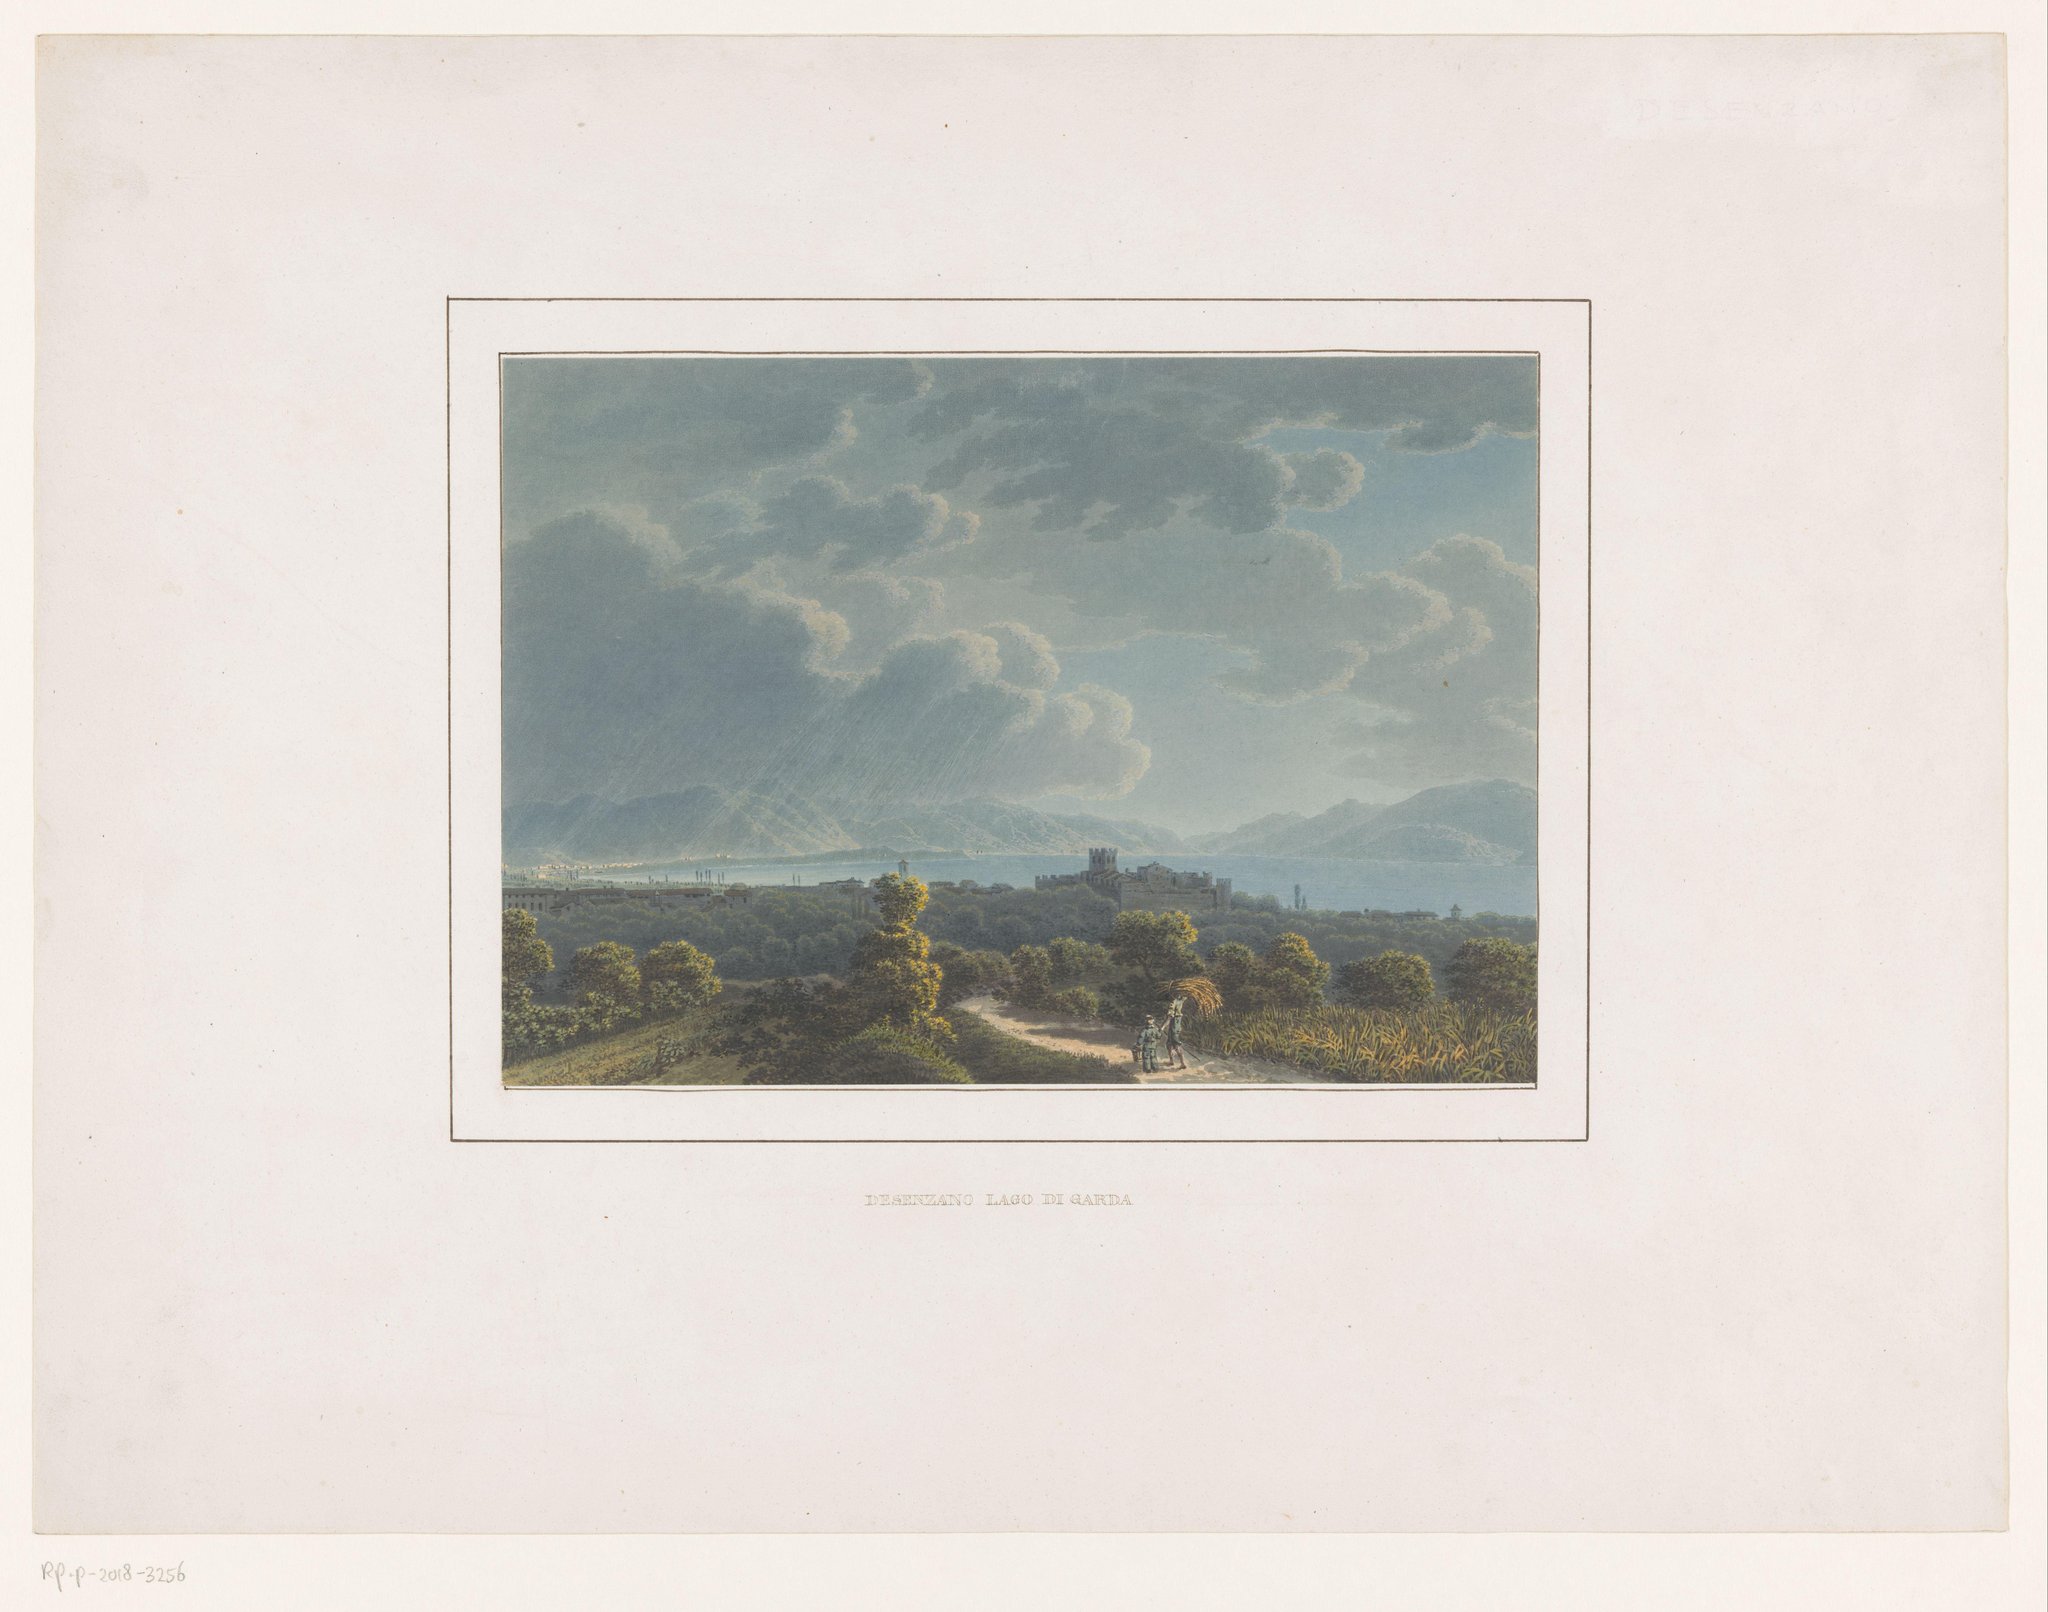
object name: print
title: Densenzano Lago di Garda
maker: Anonymous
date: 1800-1900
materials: paper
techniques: hand coloring, lithograph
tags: prospect of village, silhouette of village, lake